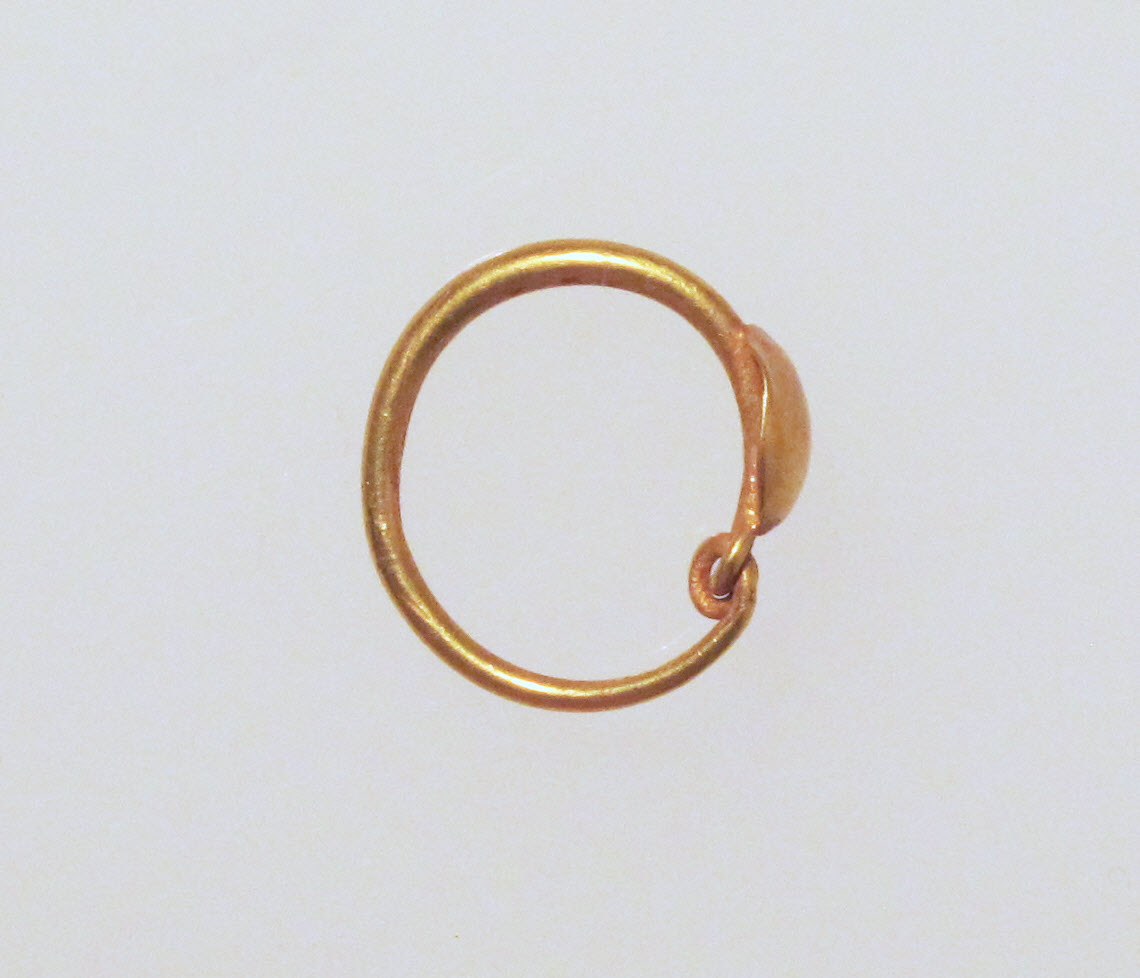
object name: earring with plain loop and disc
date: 7000 BCE-330 CE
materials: gold